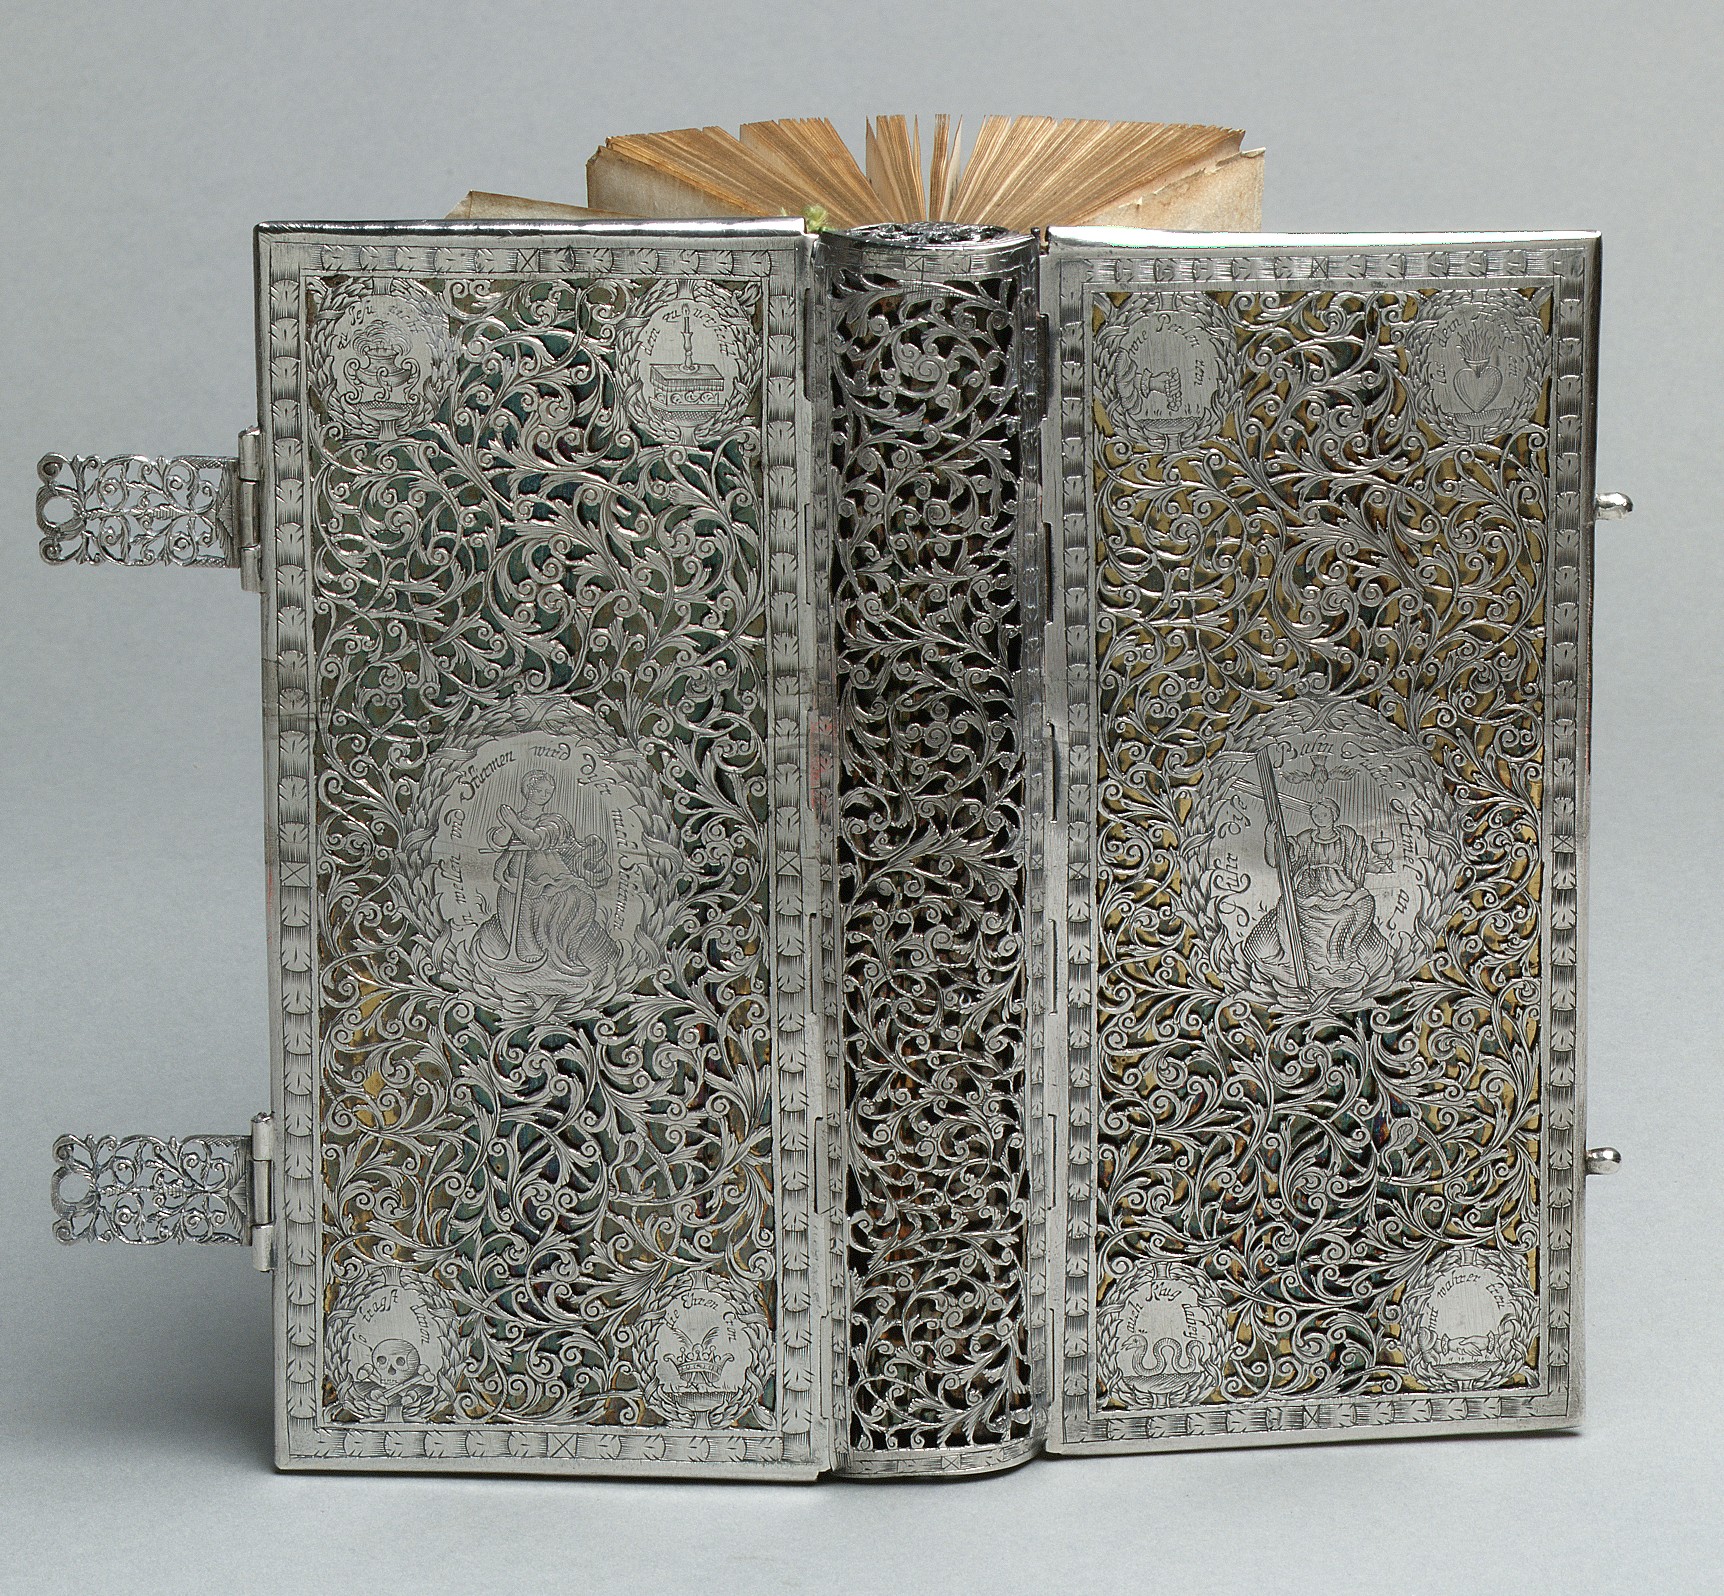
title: Doct. Johan Arndts, dess gottseligen und hocherleuchteten Lehrers Paradijss Gärtlein : welches voller christlichen Tugend-Gebete erfüllet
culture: swedish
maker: johan arndts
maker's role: author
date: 1696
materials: silver